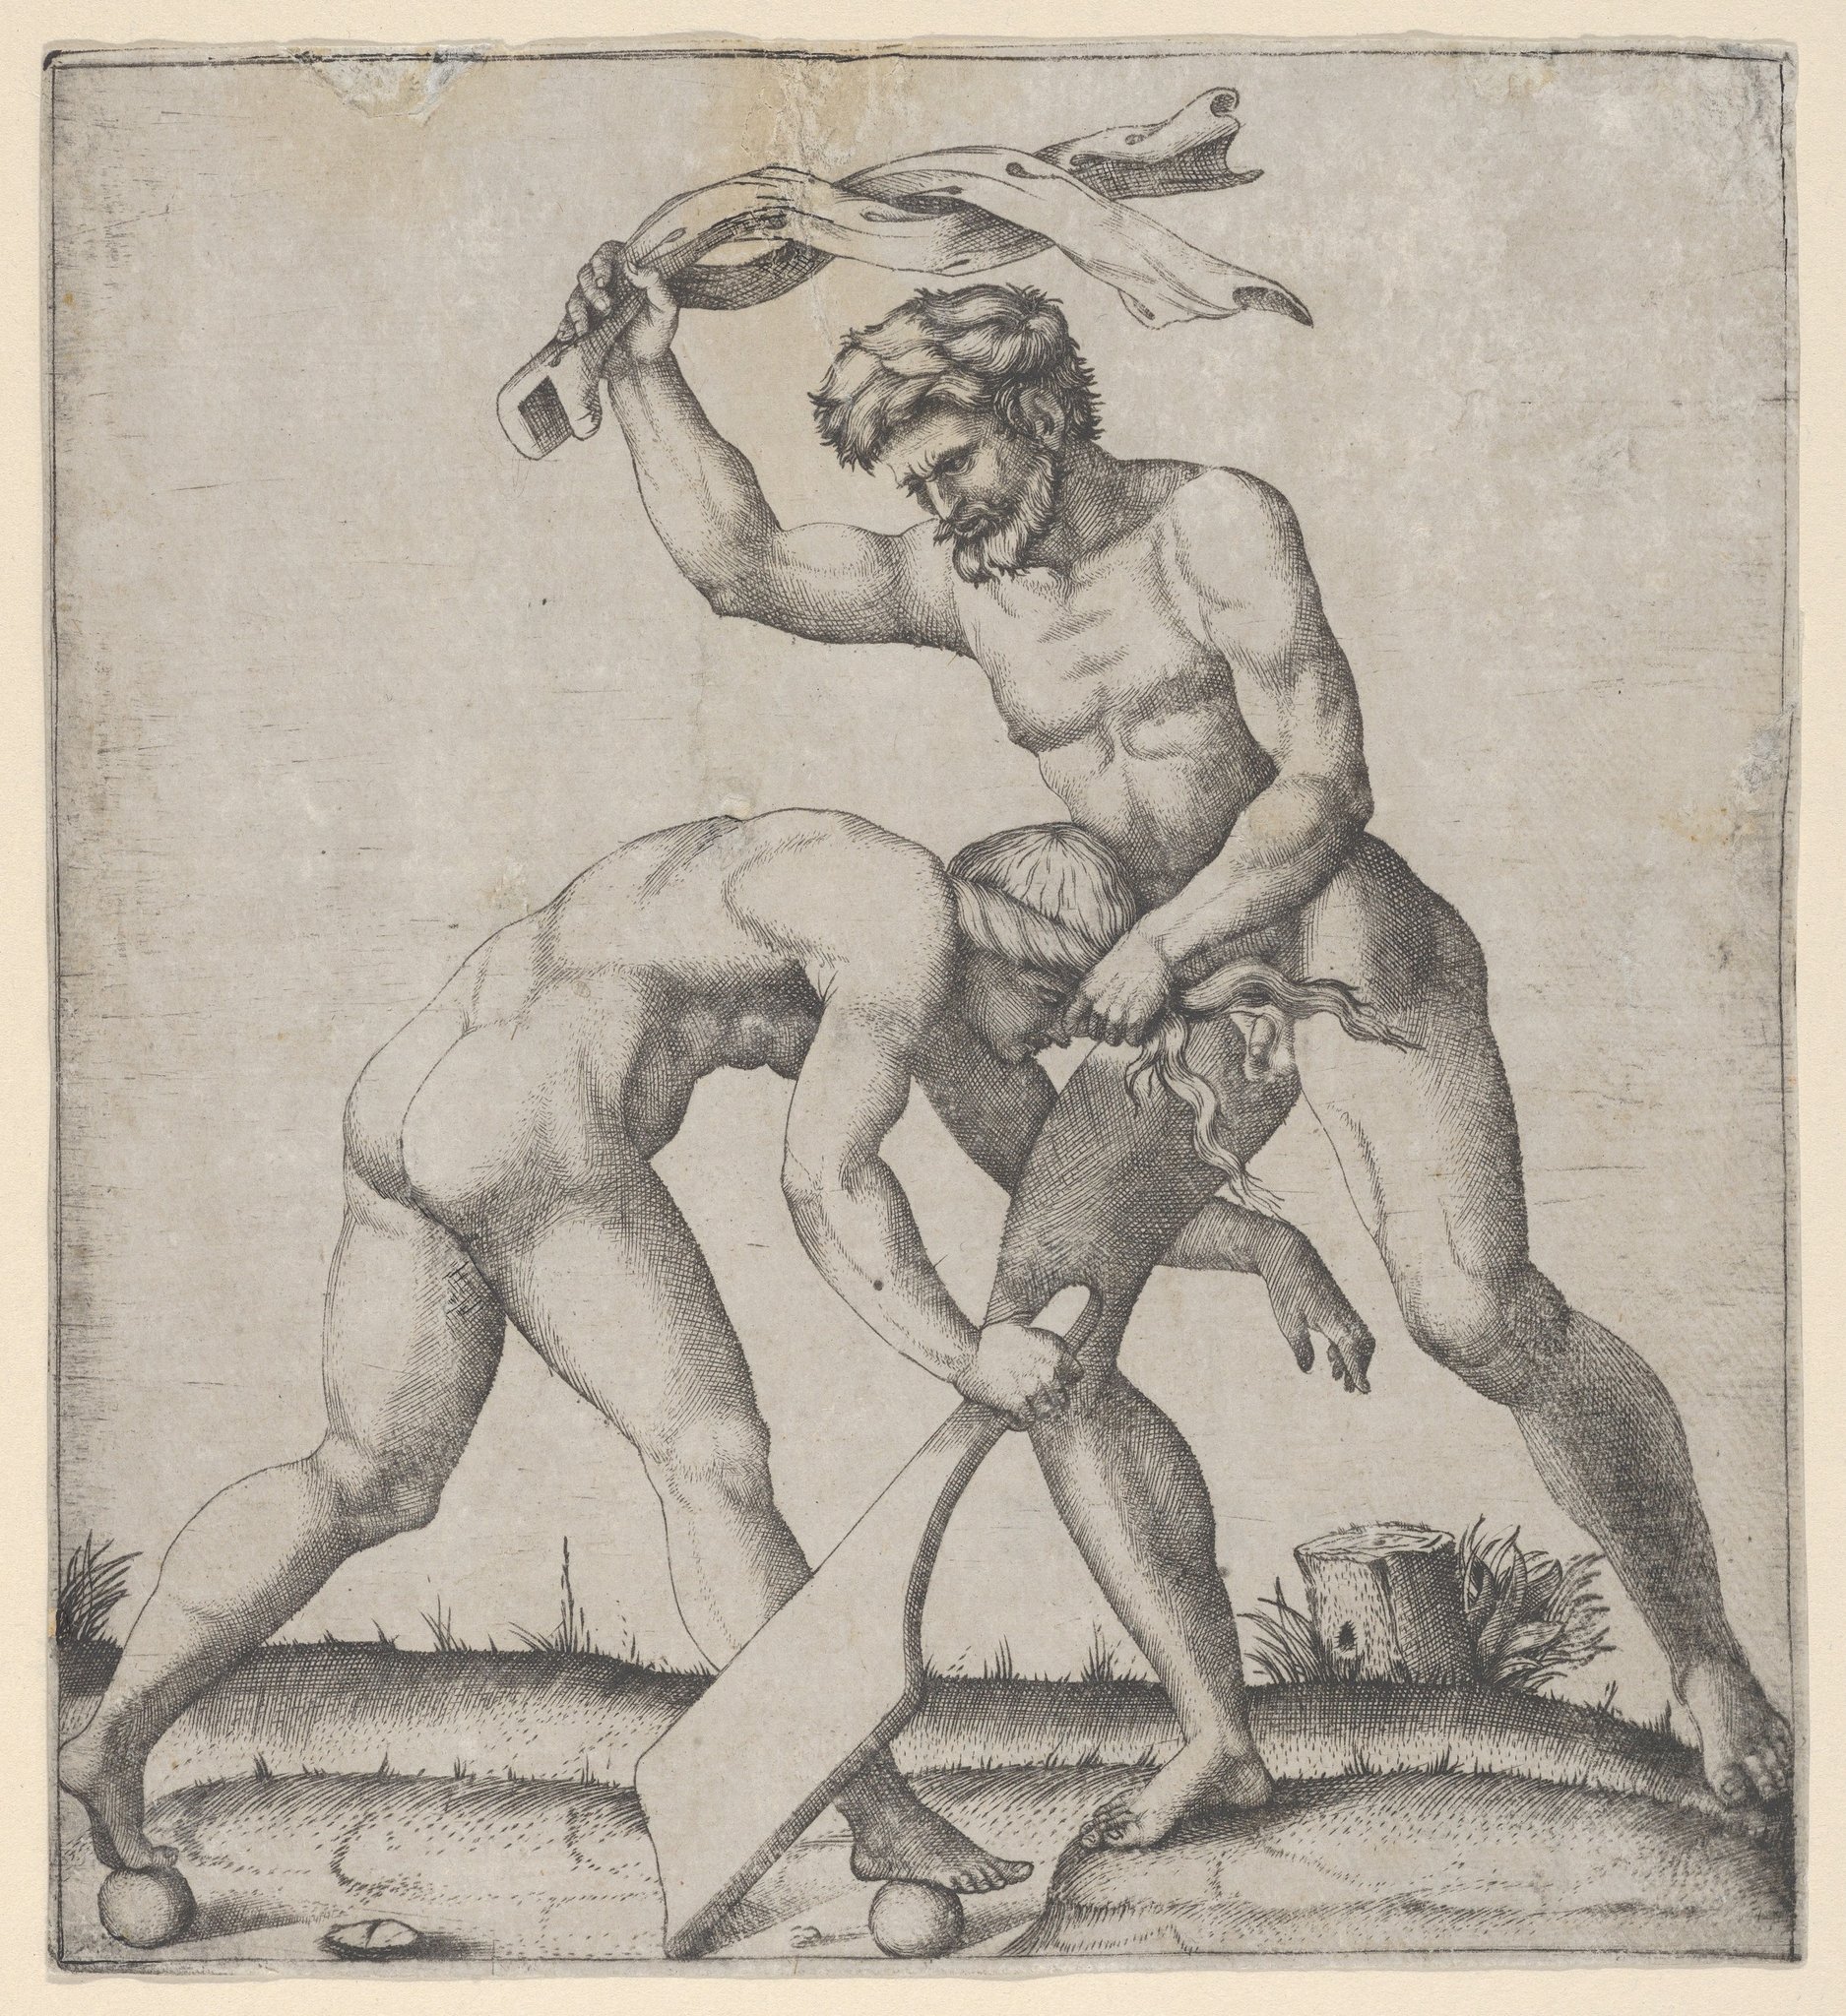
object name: print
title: A naked man holding Fortune by the hair and whipping her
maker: marcantonio raimondi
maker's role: artist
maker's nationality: italian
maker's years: 1475-1534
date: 1510-1527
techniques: engraving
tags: hair,male nudes,female nudes